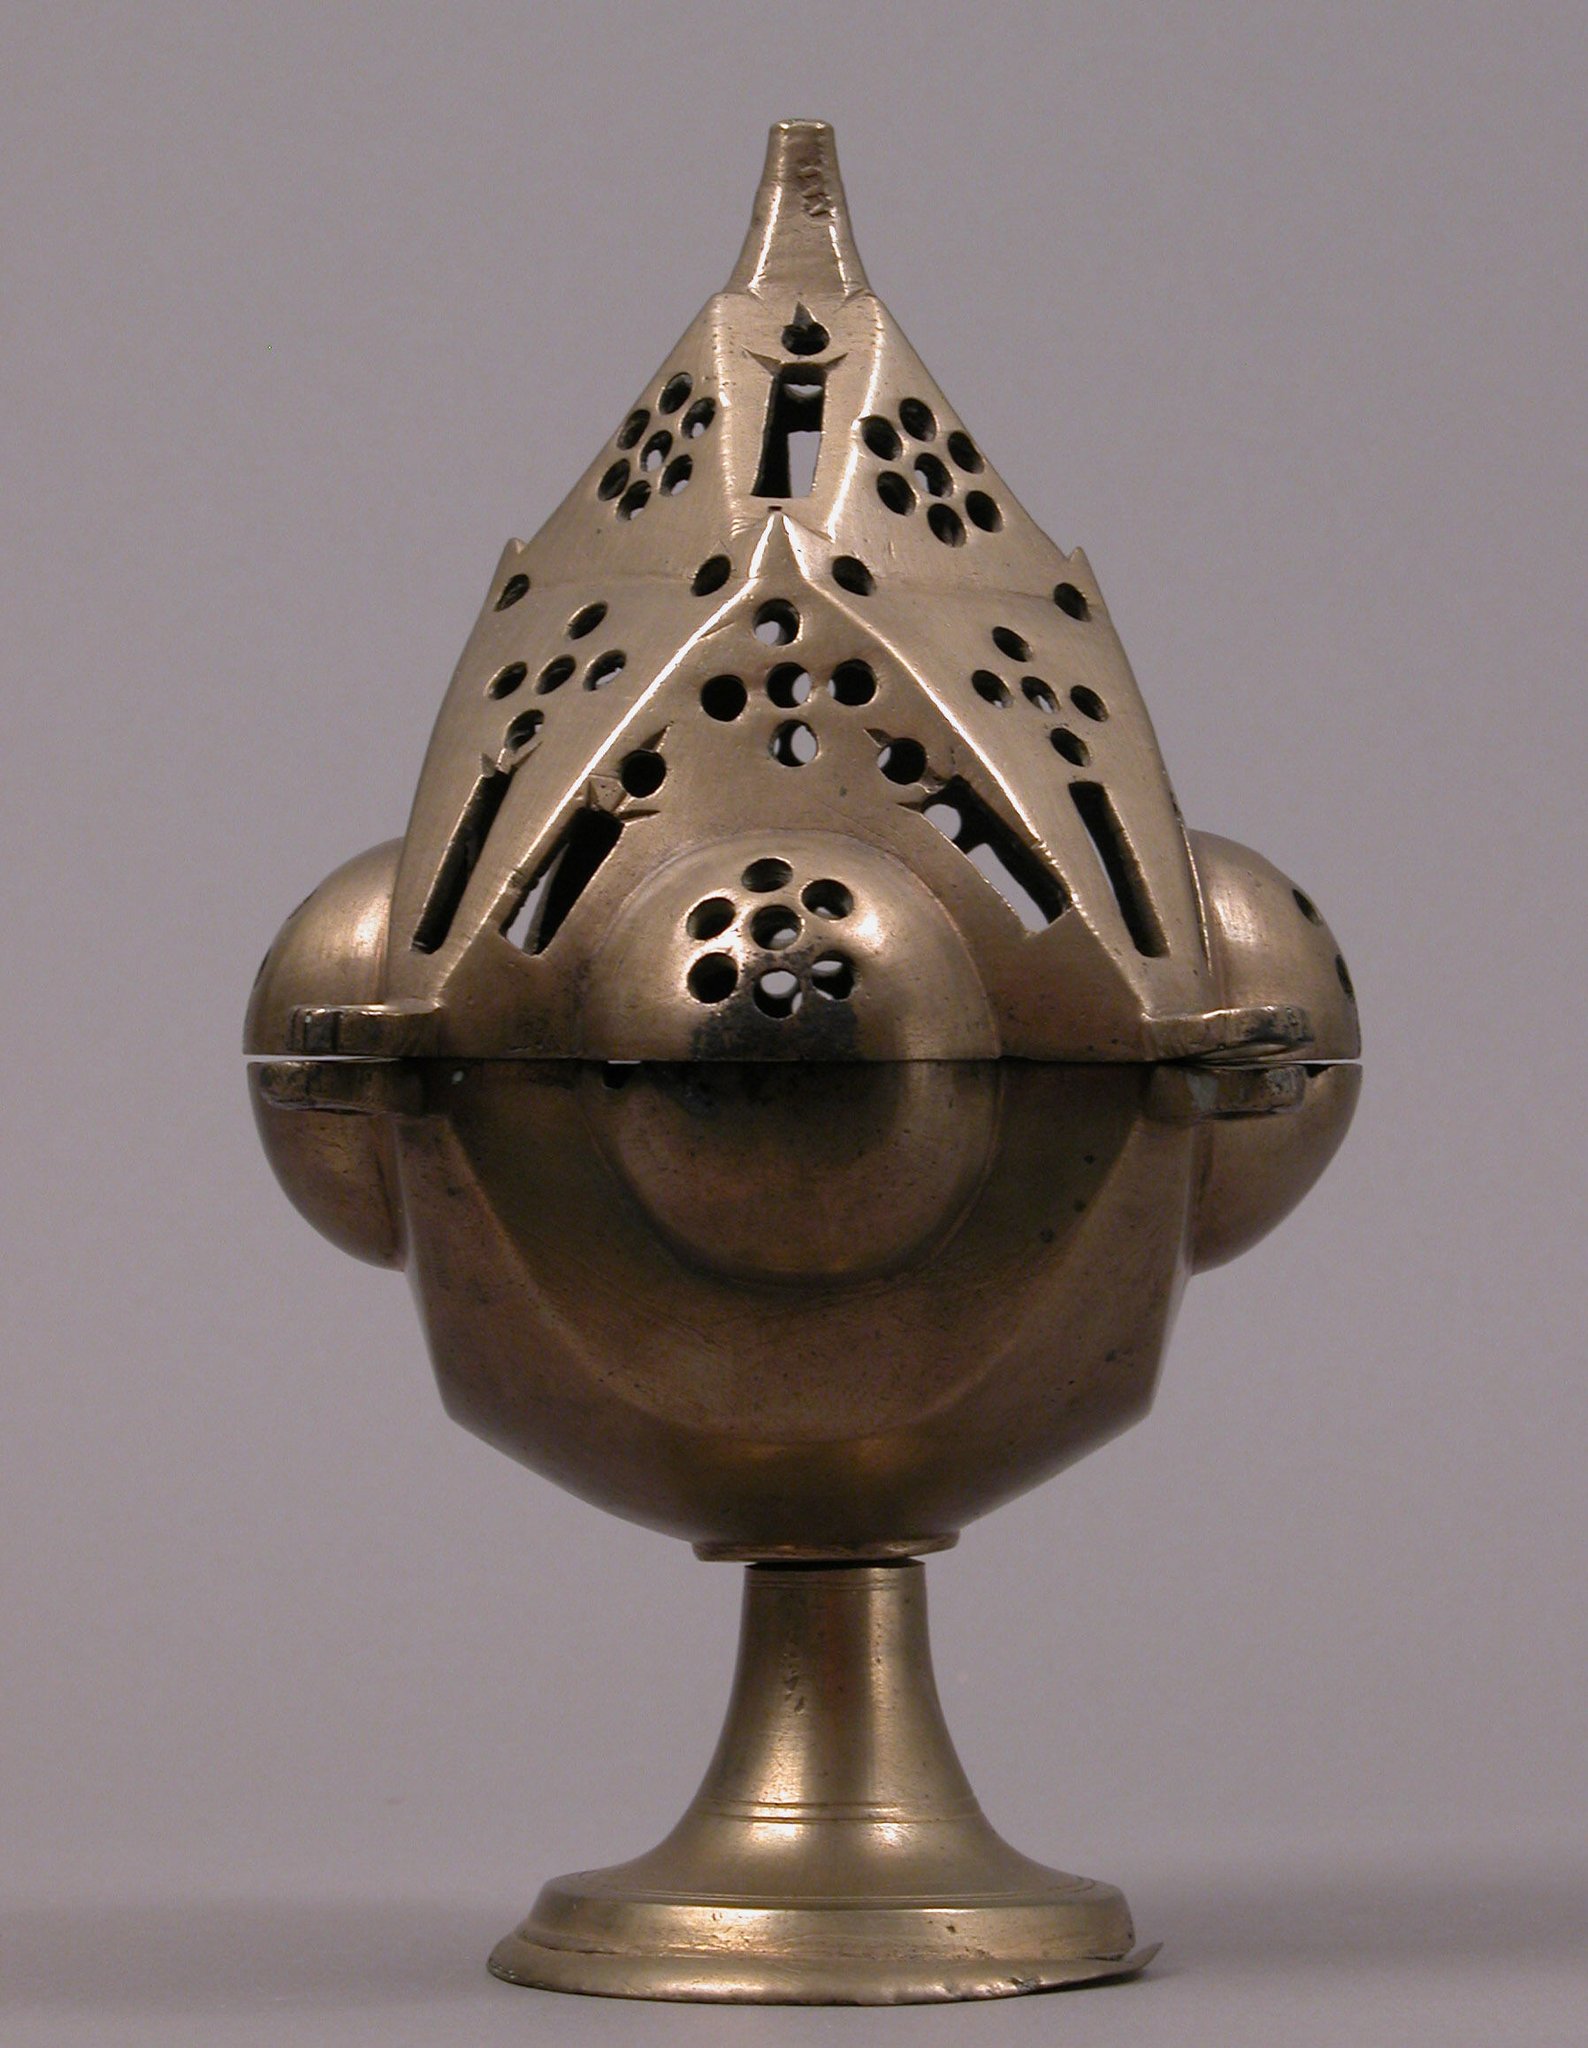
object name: censer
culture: south netherlandish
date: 1501-1600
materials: copper alloy